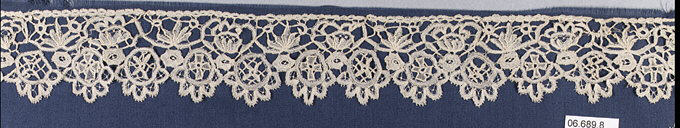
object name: piece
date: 1850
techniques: lace